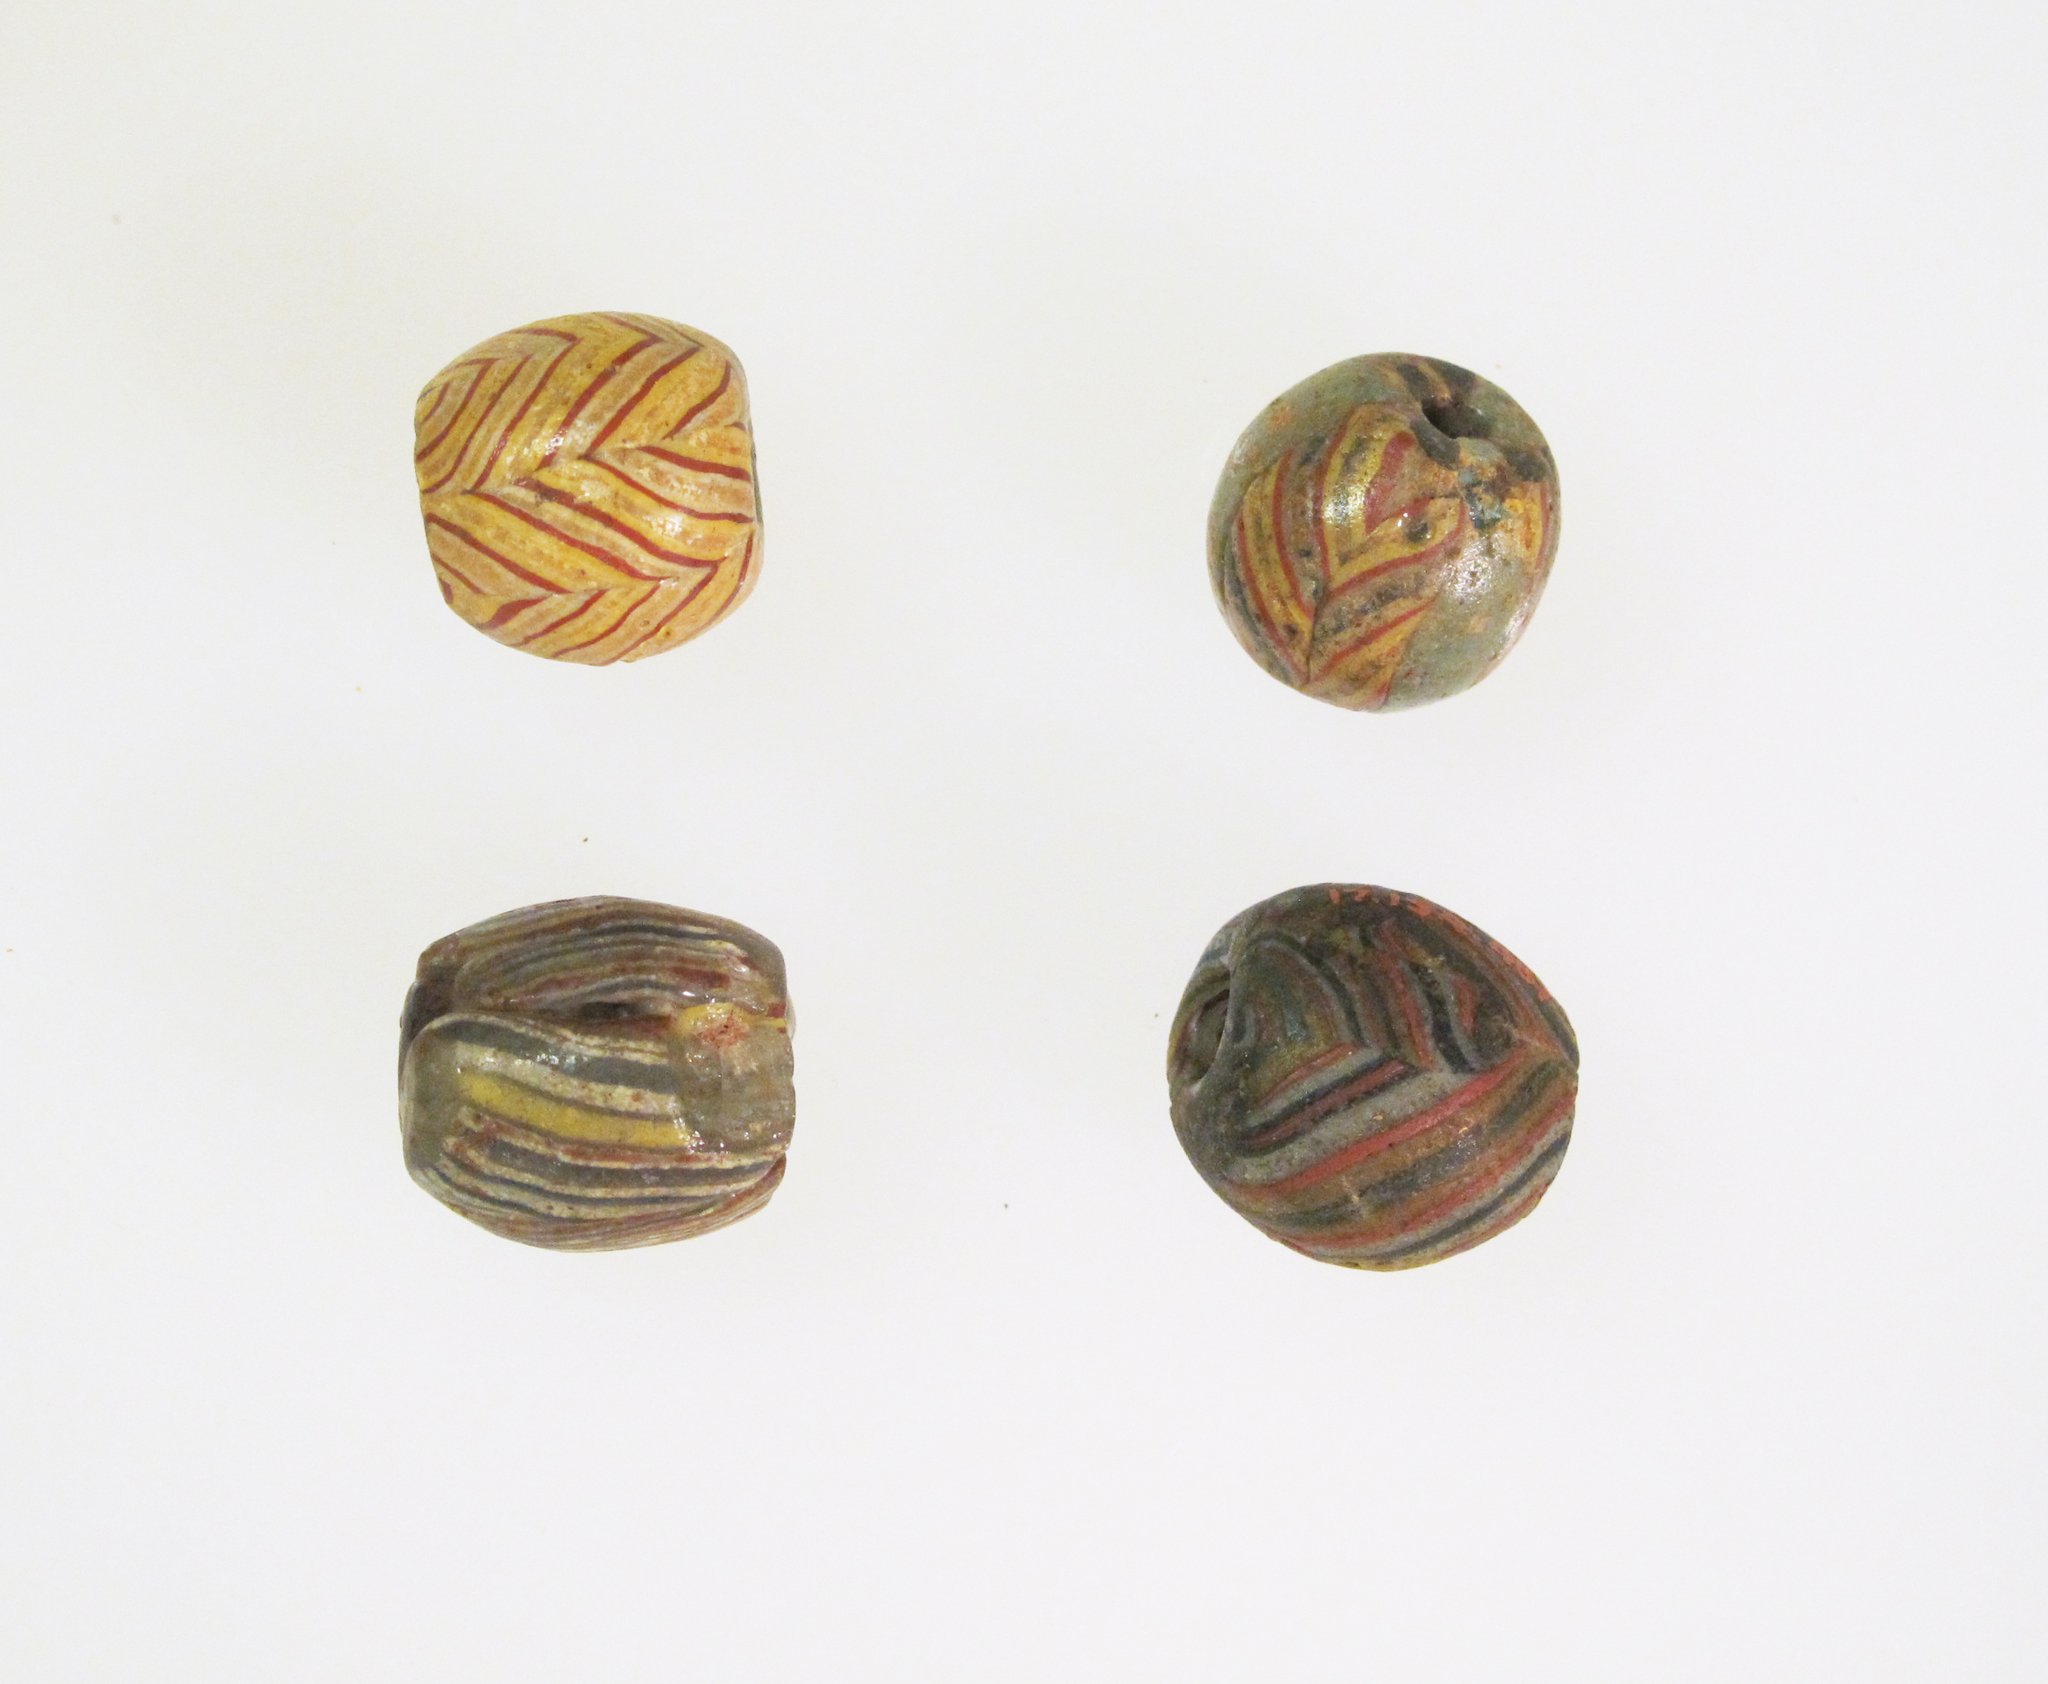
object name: bead, 4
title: Beads, 4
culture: roman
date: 670 BCE-330 CE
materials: glass